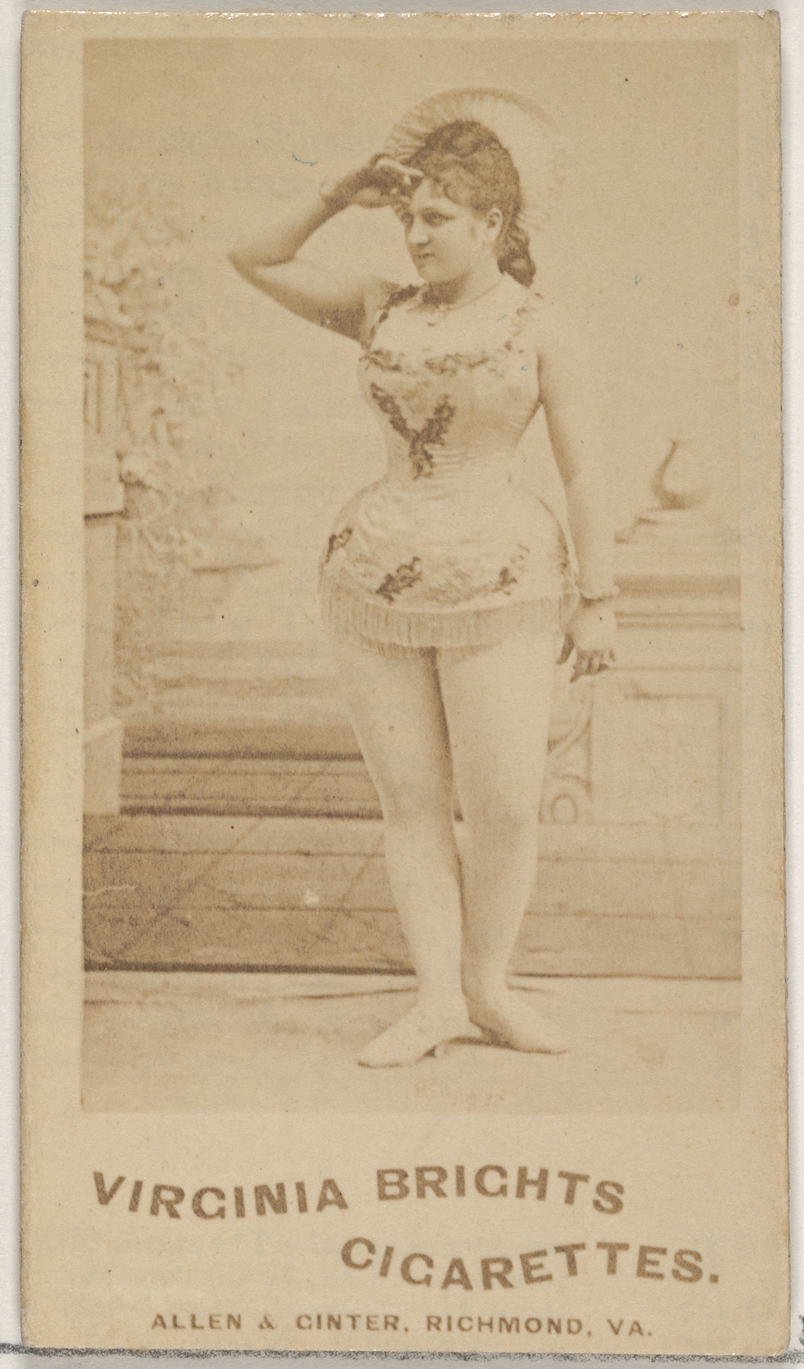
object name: photograph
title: From the Actors and Actresses series (N45, Type 5) for Virginia Brights Cigarettes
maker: allen & ginter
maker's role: publisher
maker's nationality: american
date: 1888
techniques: albumen silver print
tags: portraits,women